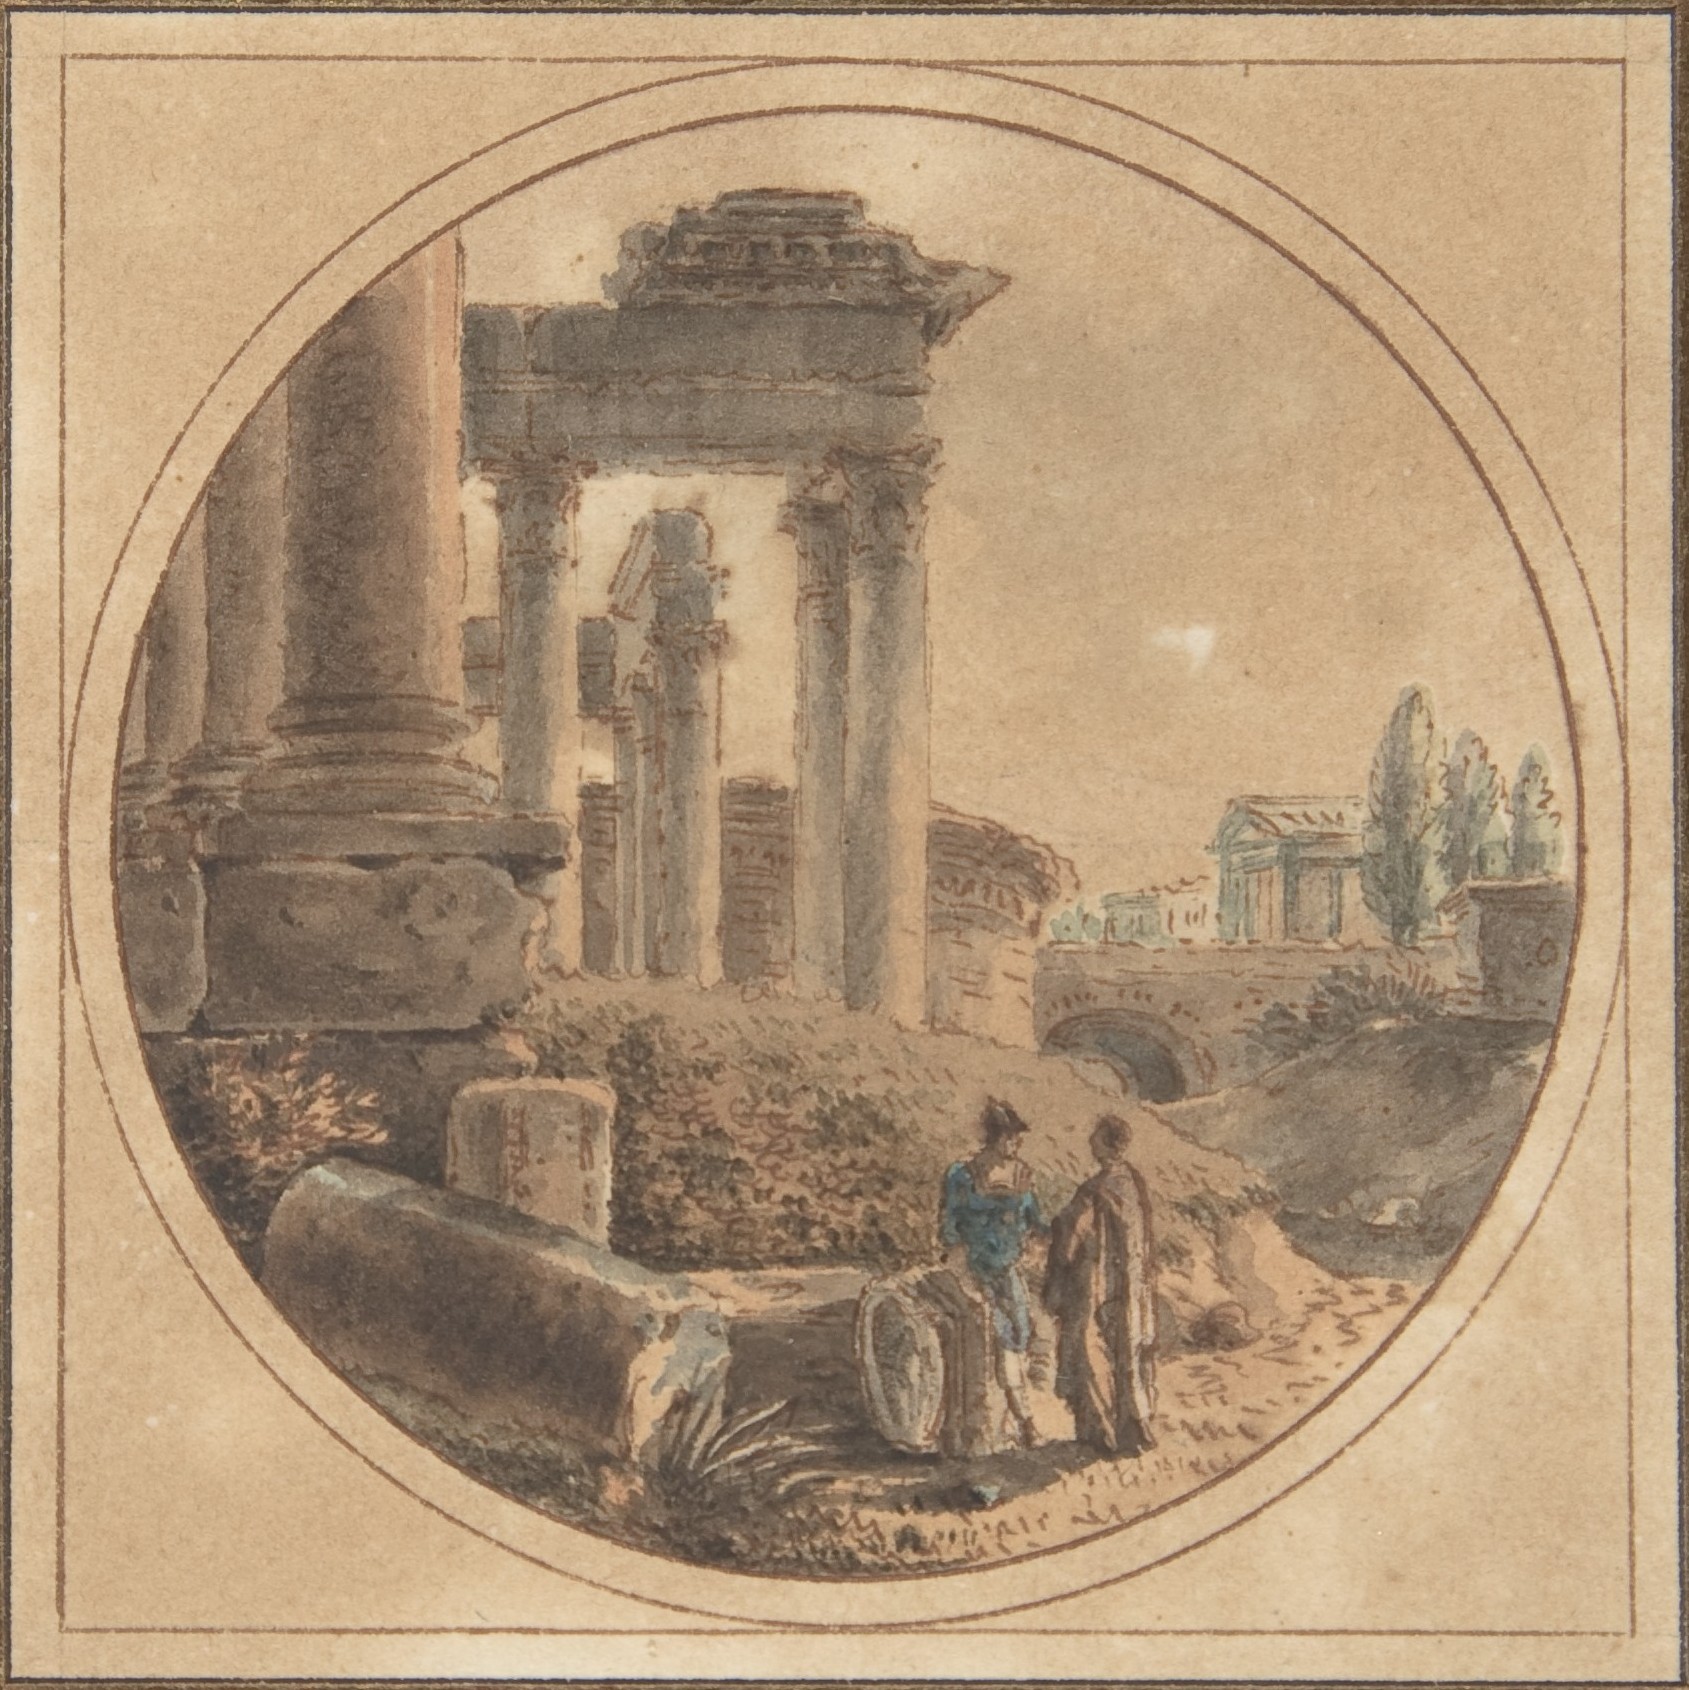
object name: drawing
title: Fantasy View of the Roman Forum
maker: victor jean nicolle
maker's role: artist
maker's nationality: french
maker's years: 1754-1826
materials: ink, watercolor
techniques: pen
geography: france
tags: ruins,rome